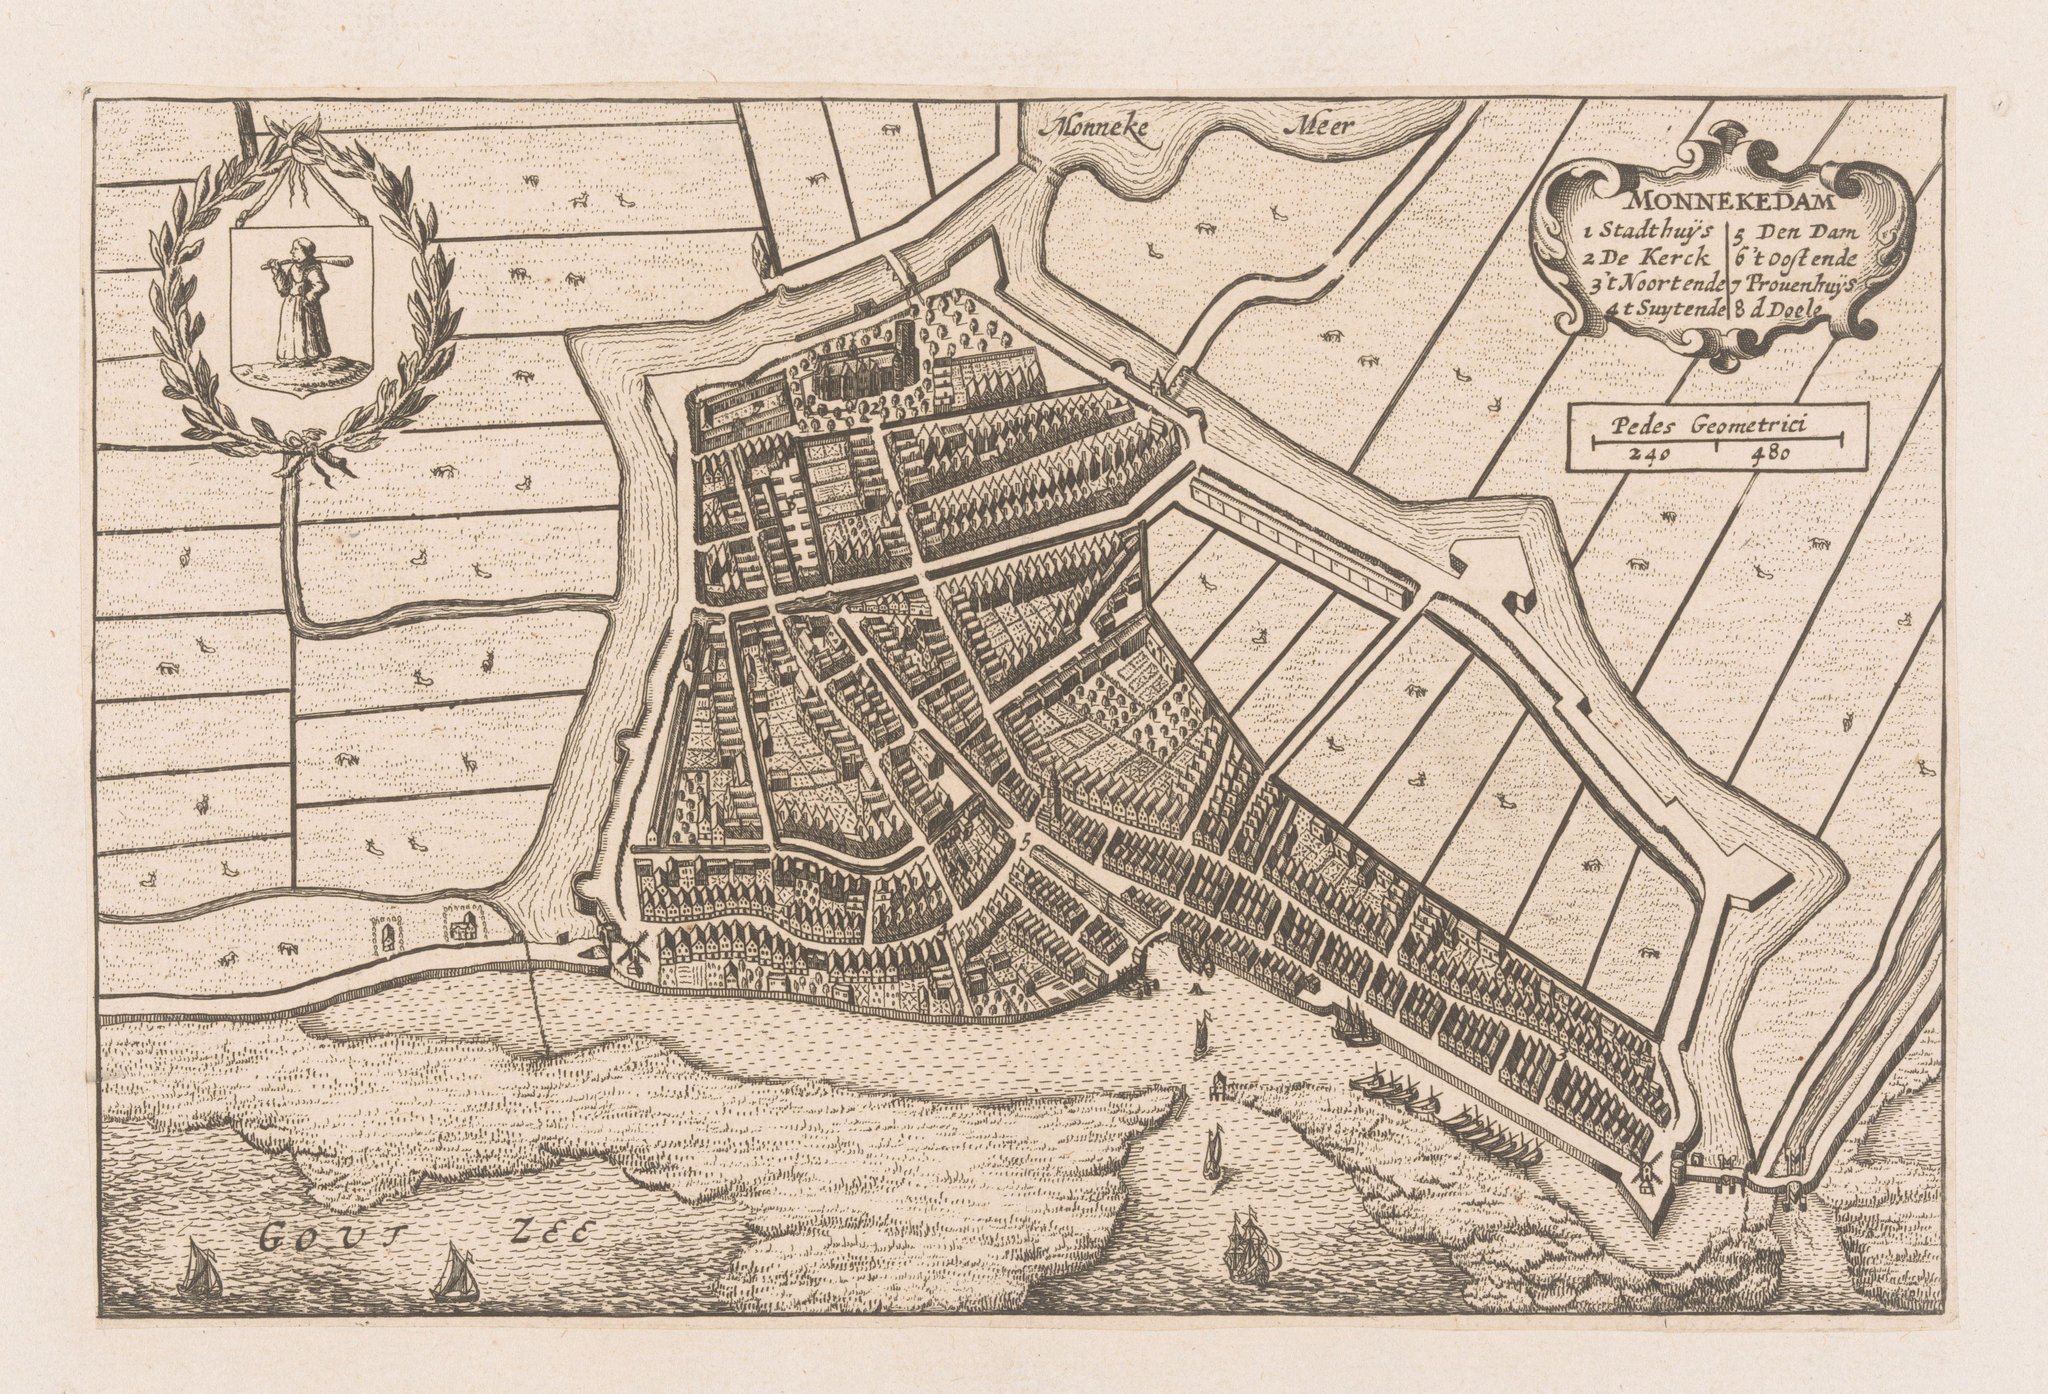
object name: area plan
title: Monnekedam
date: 1649-1652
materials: paper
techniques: etching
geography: amsterdam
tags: maps of cities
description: Prent gebruikt in: Blaeu, Johannes Willemszoon. Toonneel der steden van de Vereenighde Nederlanden. 2 dln. Amsterdam: Johannes Willemszoon Blaeu, 1652, dl. 1.